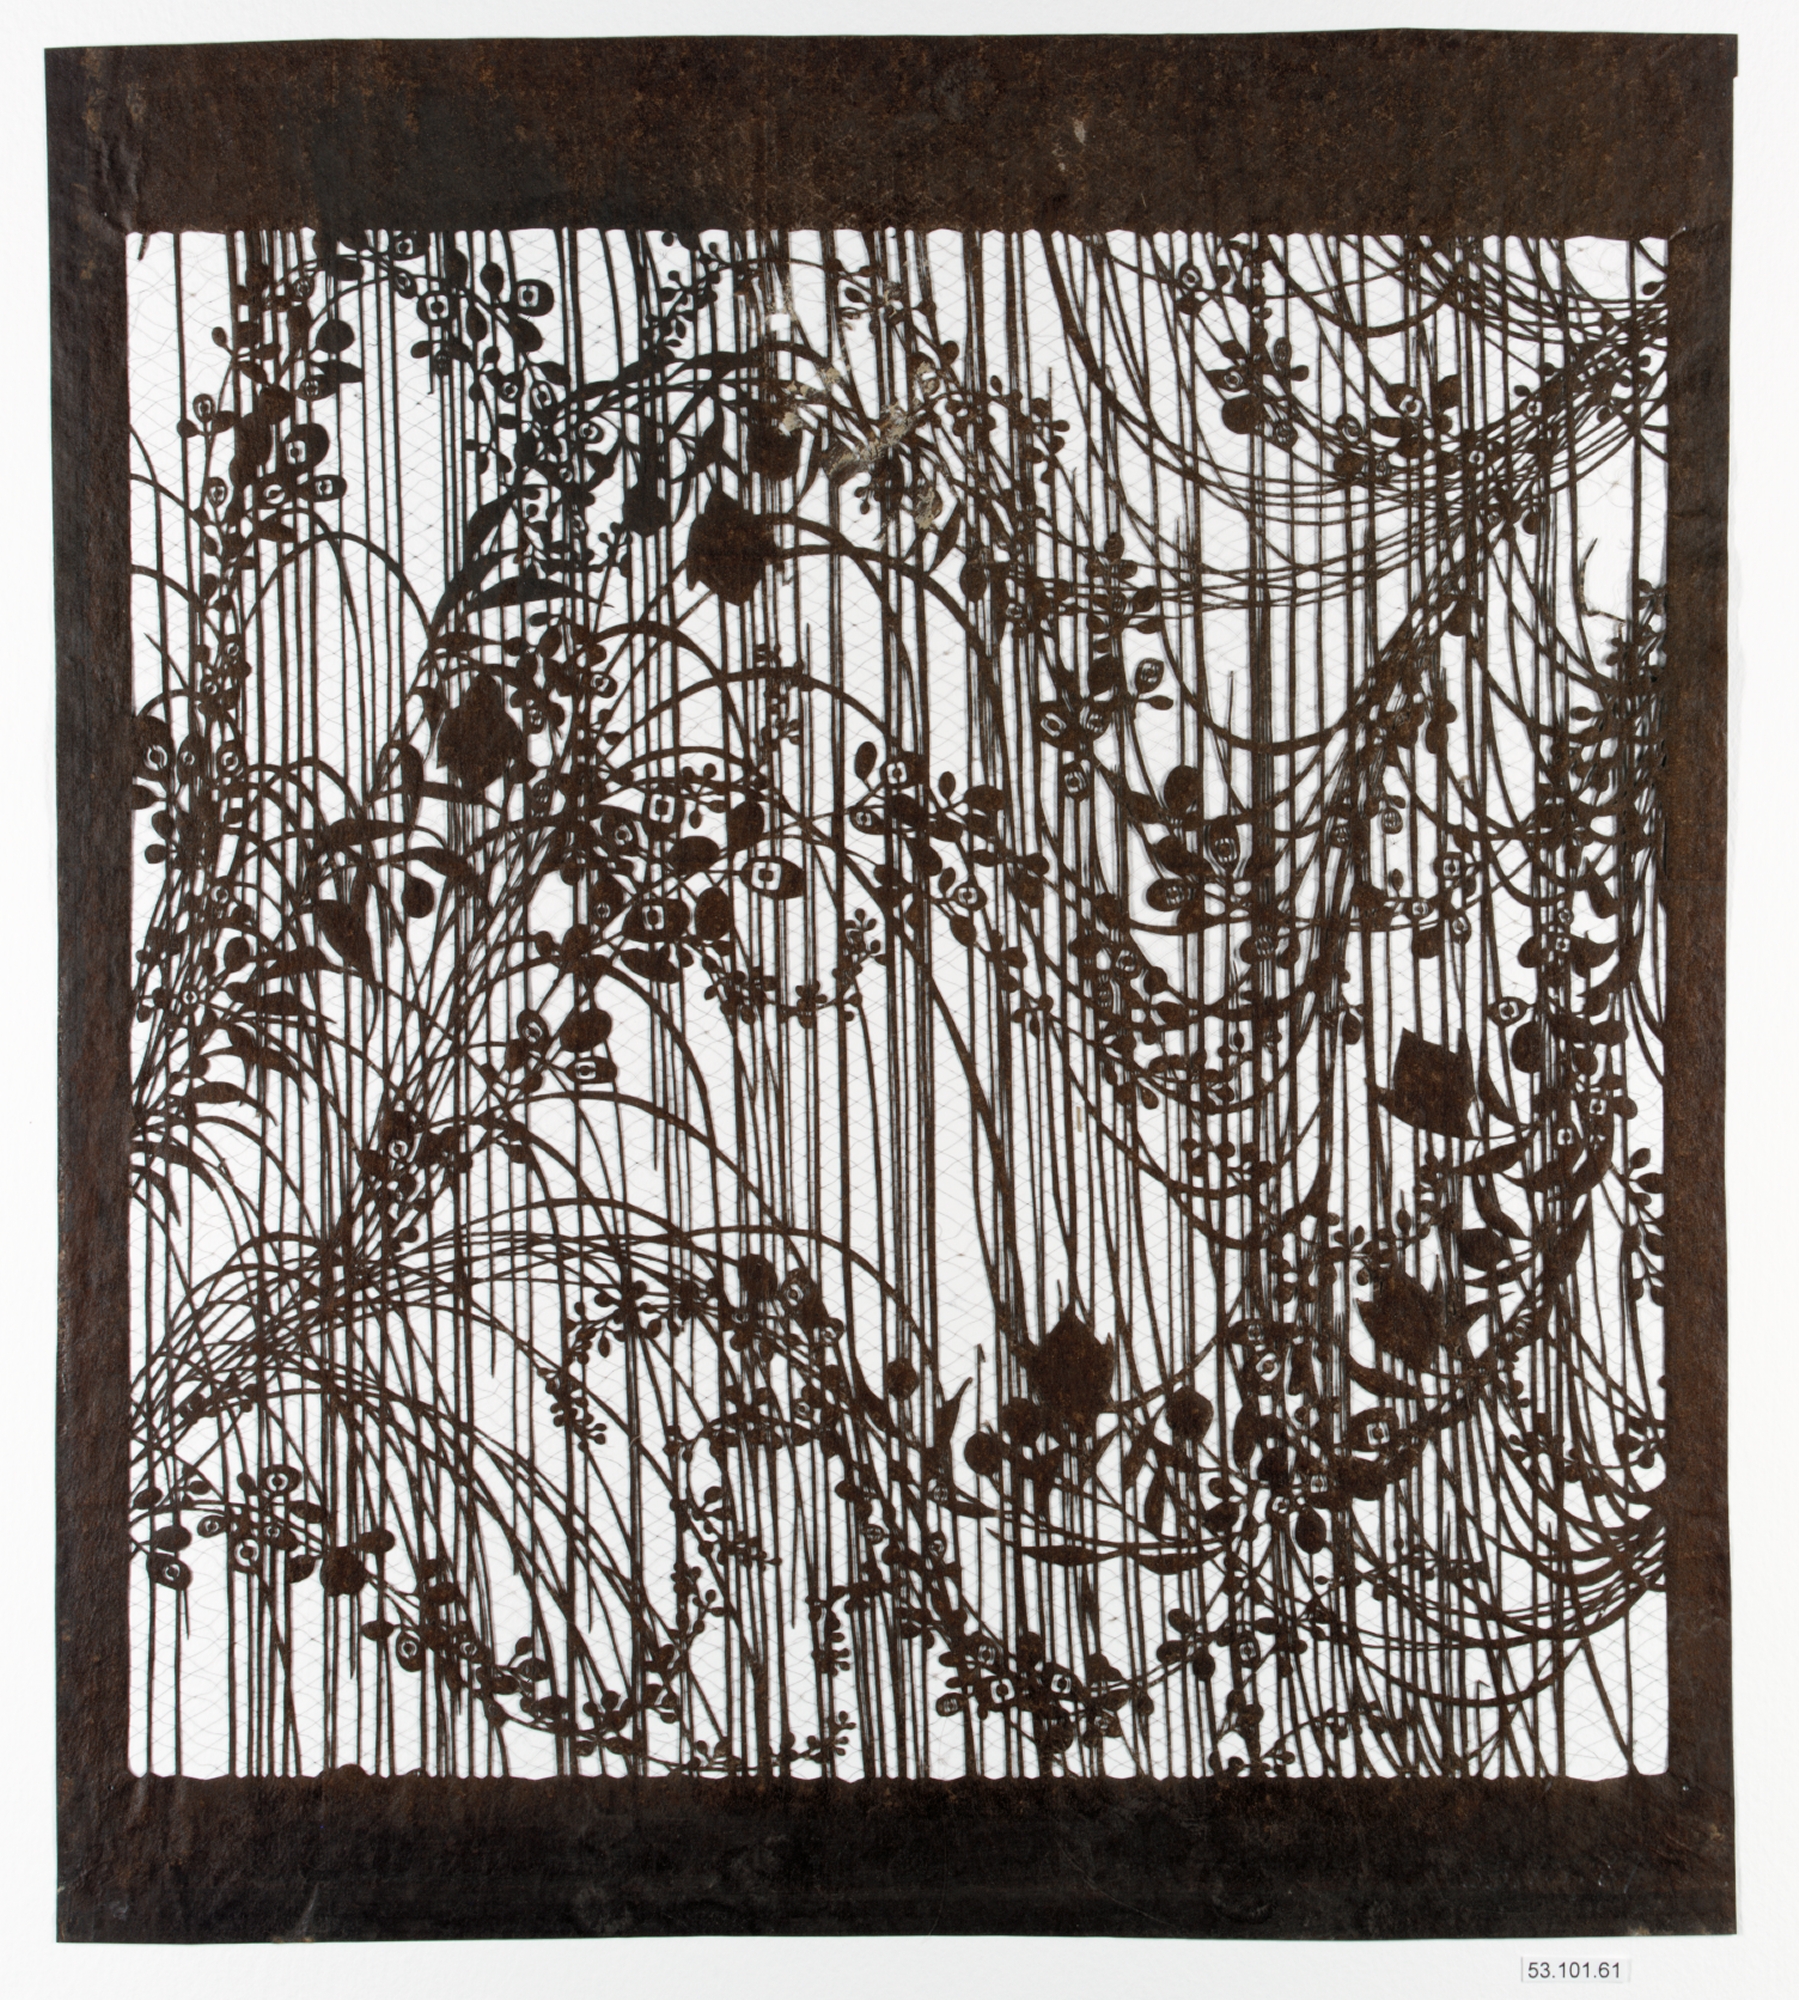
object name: stencil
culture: japanese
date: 1615-1868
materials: paper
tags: plants